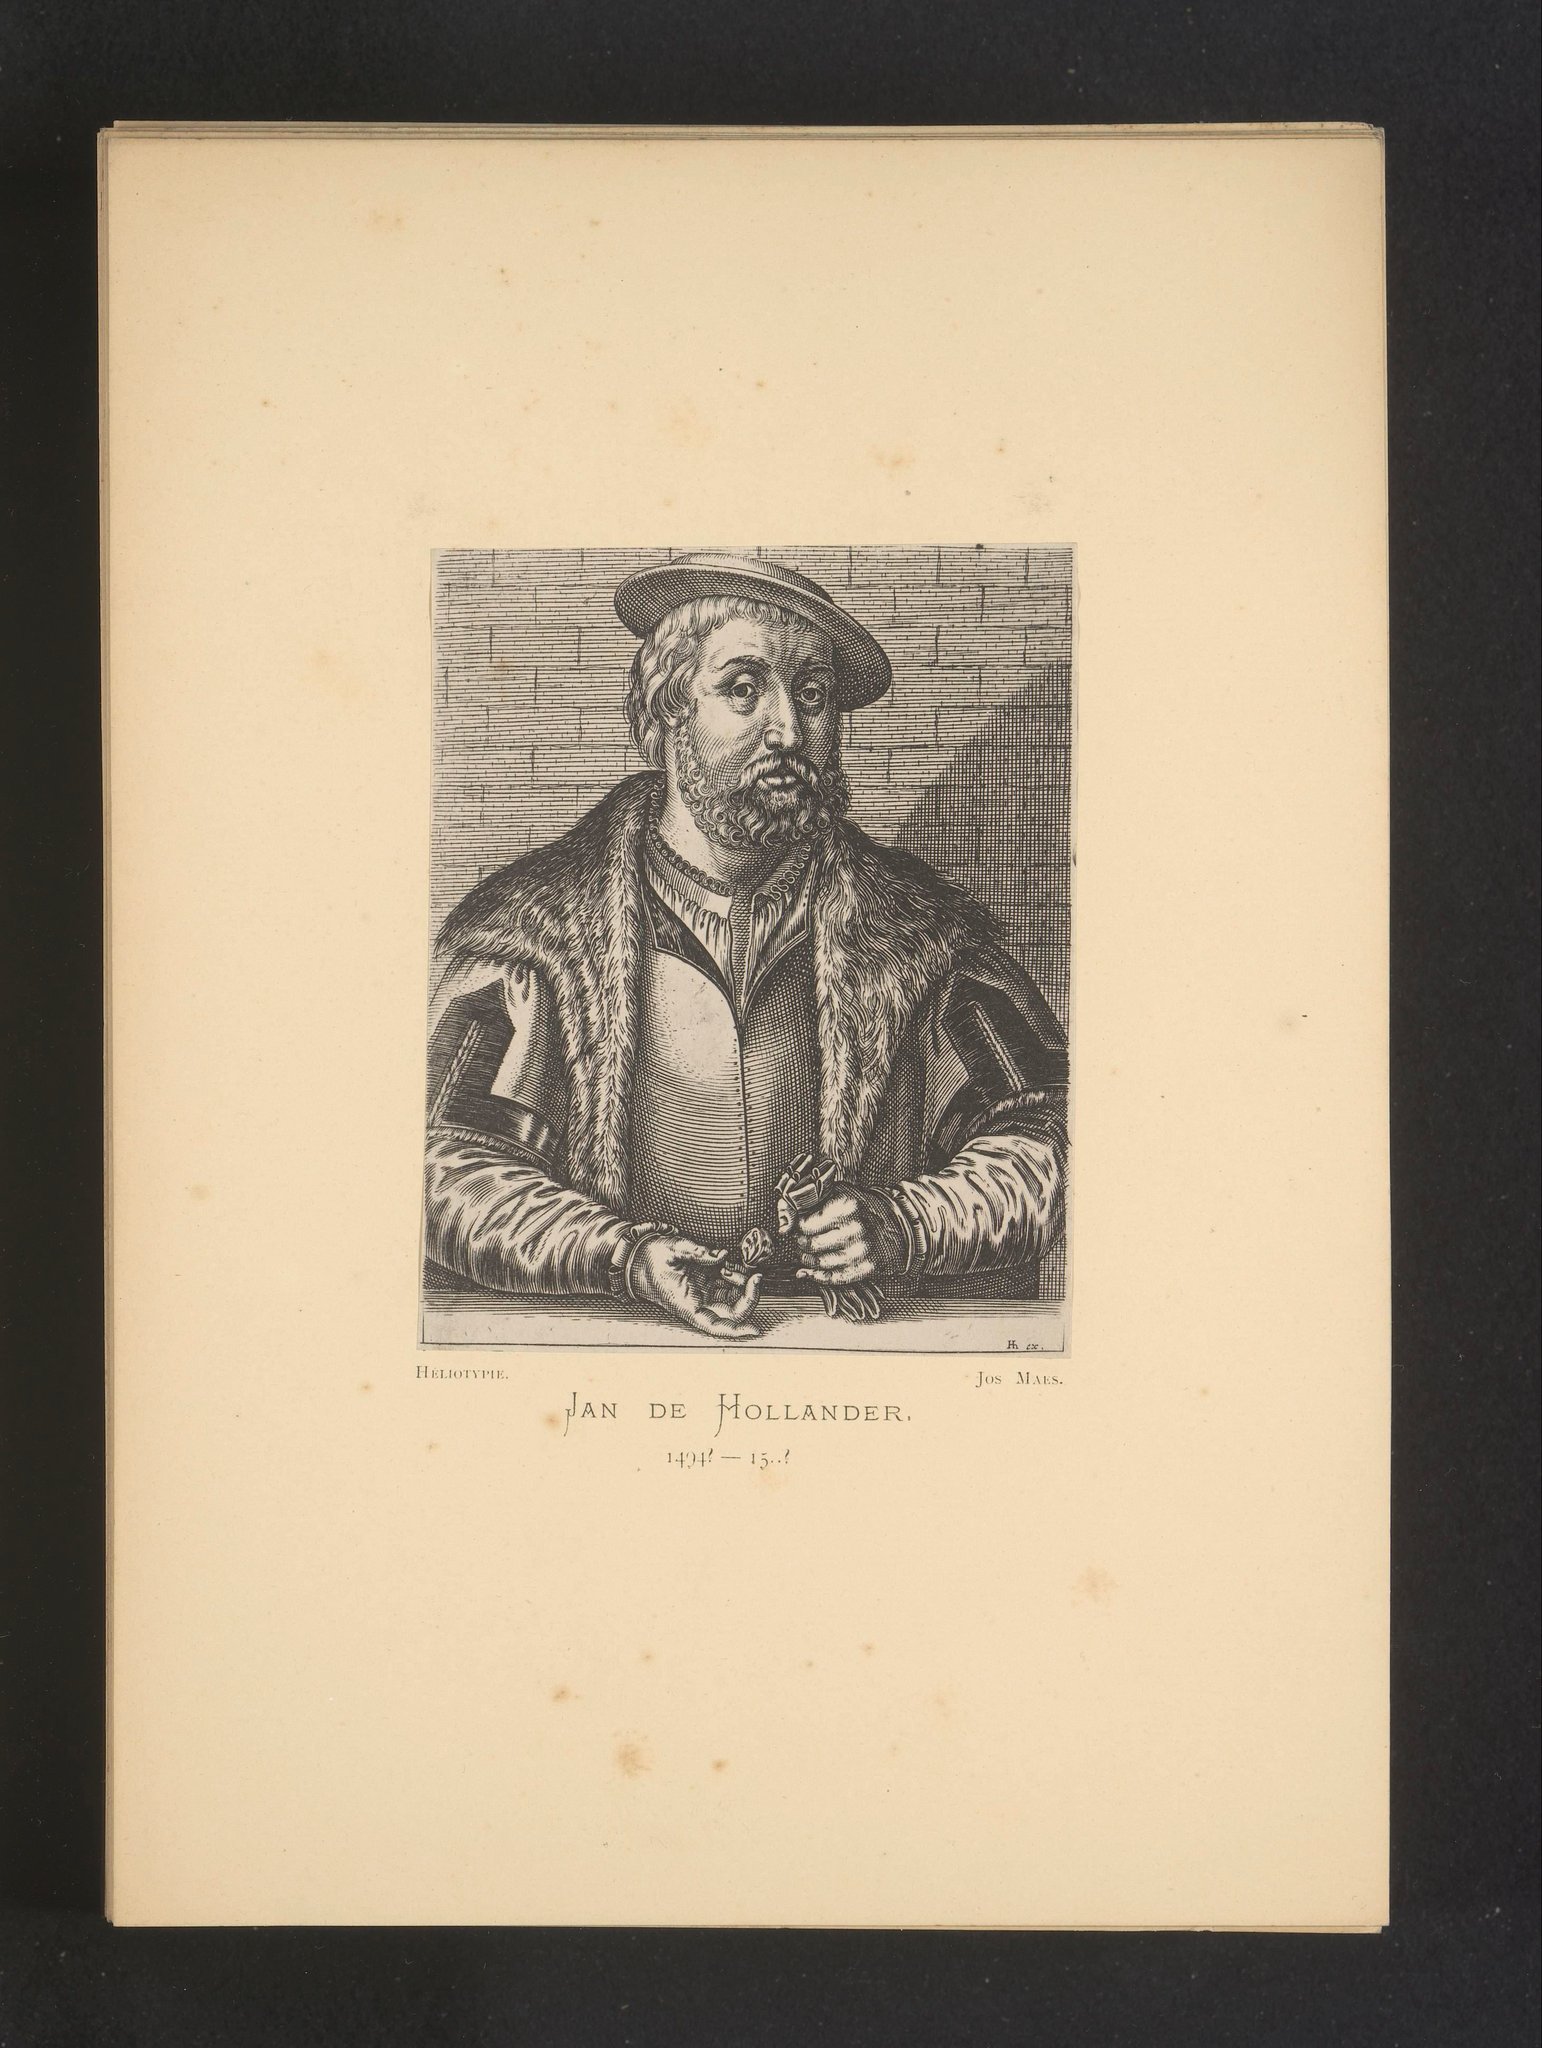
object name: photomechanical print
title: Reproductie van een gravure van een portret van Jan van Amstel door Hendrick Hondius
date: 1872-1877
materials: cardboard, paper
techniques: photograph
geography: antwerp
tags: amsterdam, antwerp, painter, draughtsman, historical persons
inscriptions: inscription: ‘1494? - 15..?’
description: Deze prent maakt deel uit van een omslag met 150 prenten en een katern met een lijst van afbeeldingen.